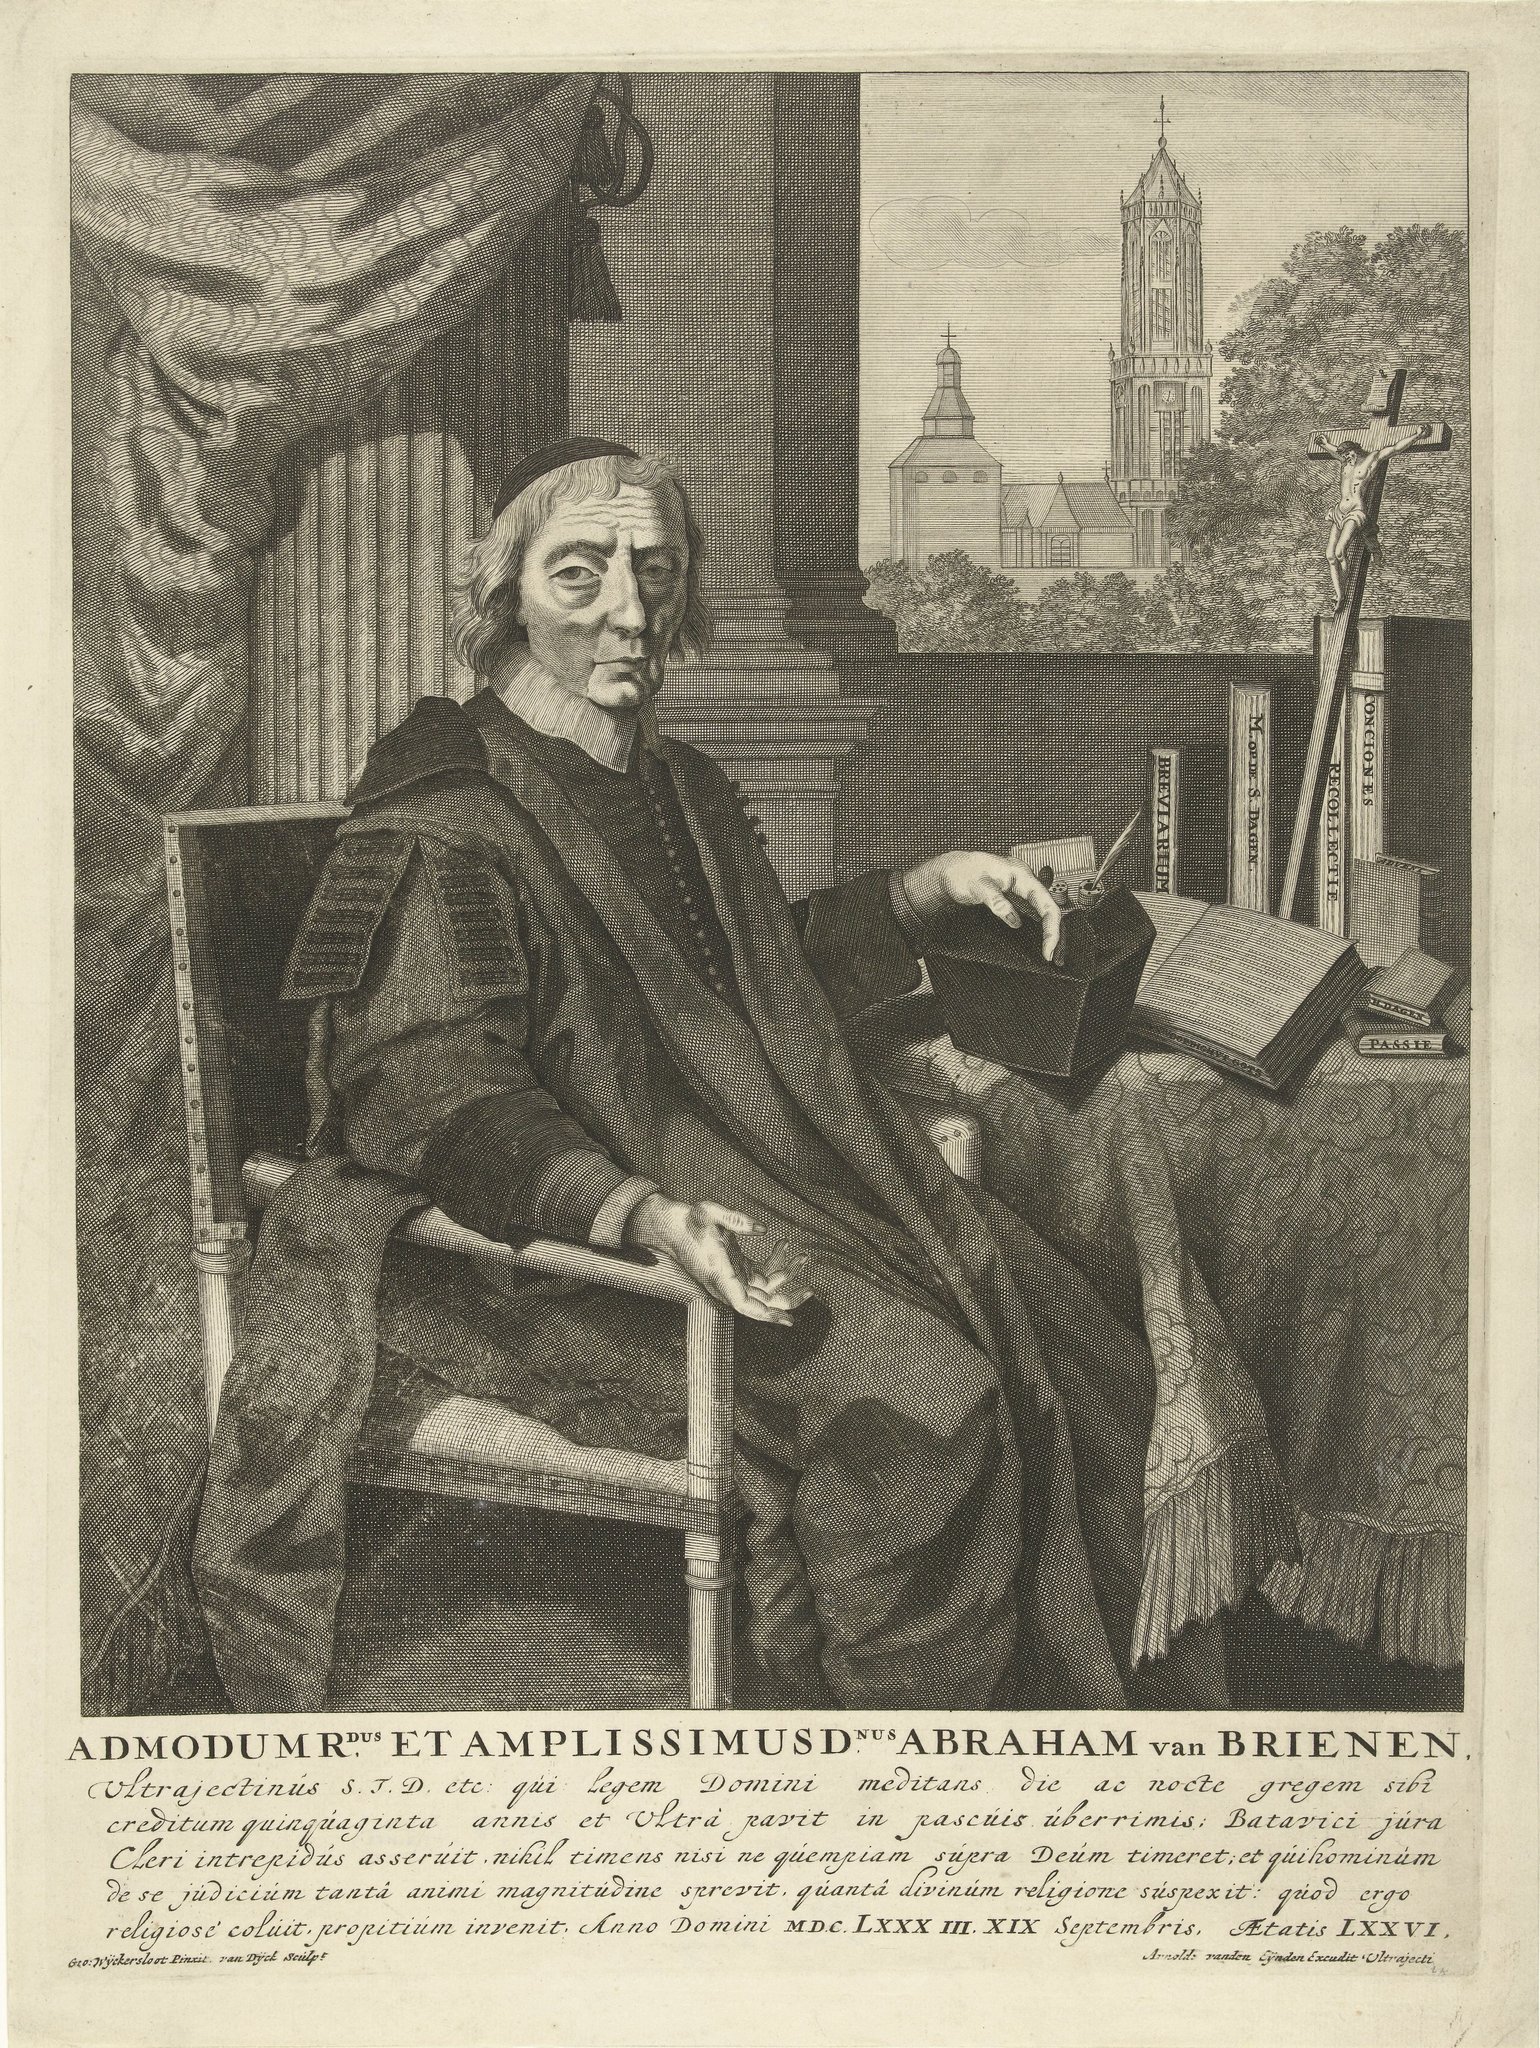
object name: print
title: Portret van pastoor Abraham van Brienen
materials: paper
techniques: engraving, etching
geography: netherlands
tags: theoloog, abraham van brienen, domtoren, buurkerk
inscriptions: collector's mark: Lugt 2166, collector's mark: Lugt 2760, collector's mark: Lugt 2228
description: Portret van pastoor Abraham van Brienen in zijn studeervertrek met uitzicht op de domtoren en de buurkerk in Utrecht. Van Brienen zit aan tafel en leunt met zijn linkerhand op zijn baret. Op tafel staat een crucifix en een verzameling devotionele boeken.